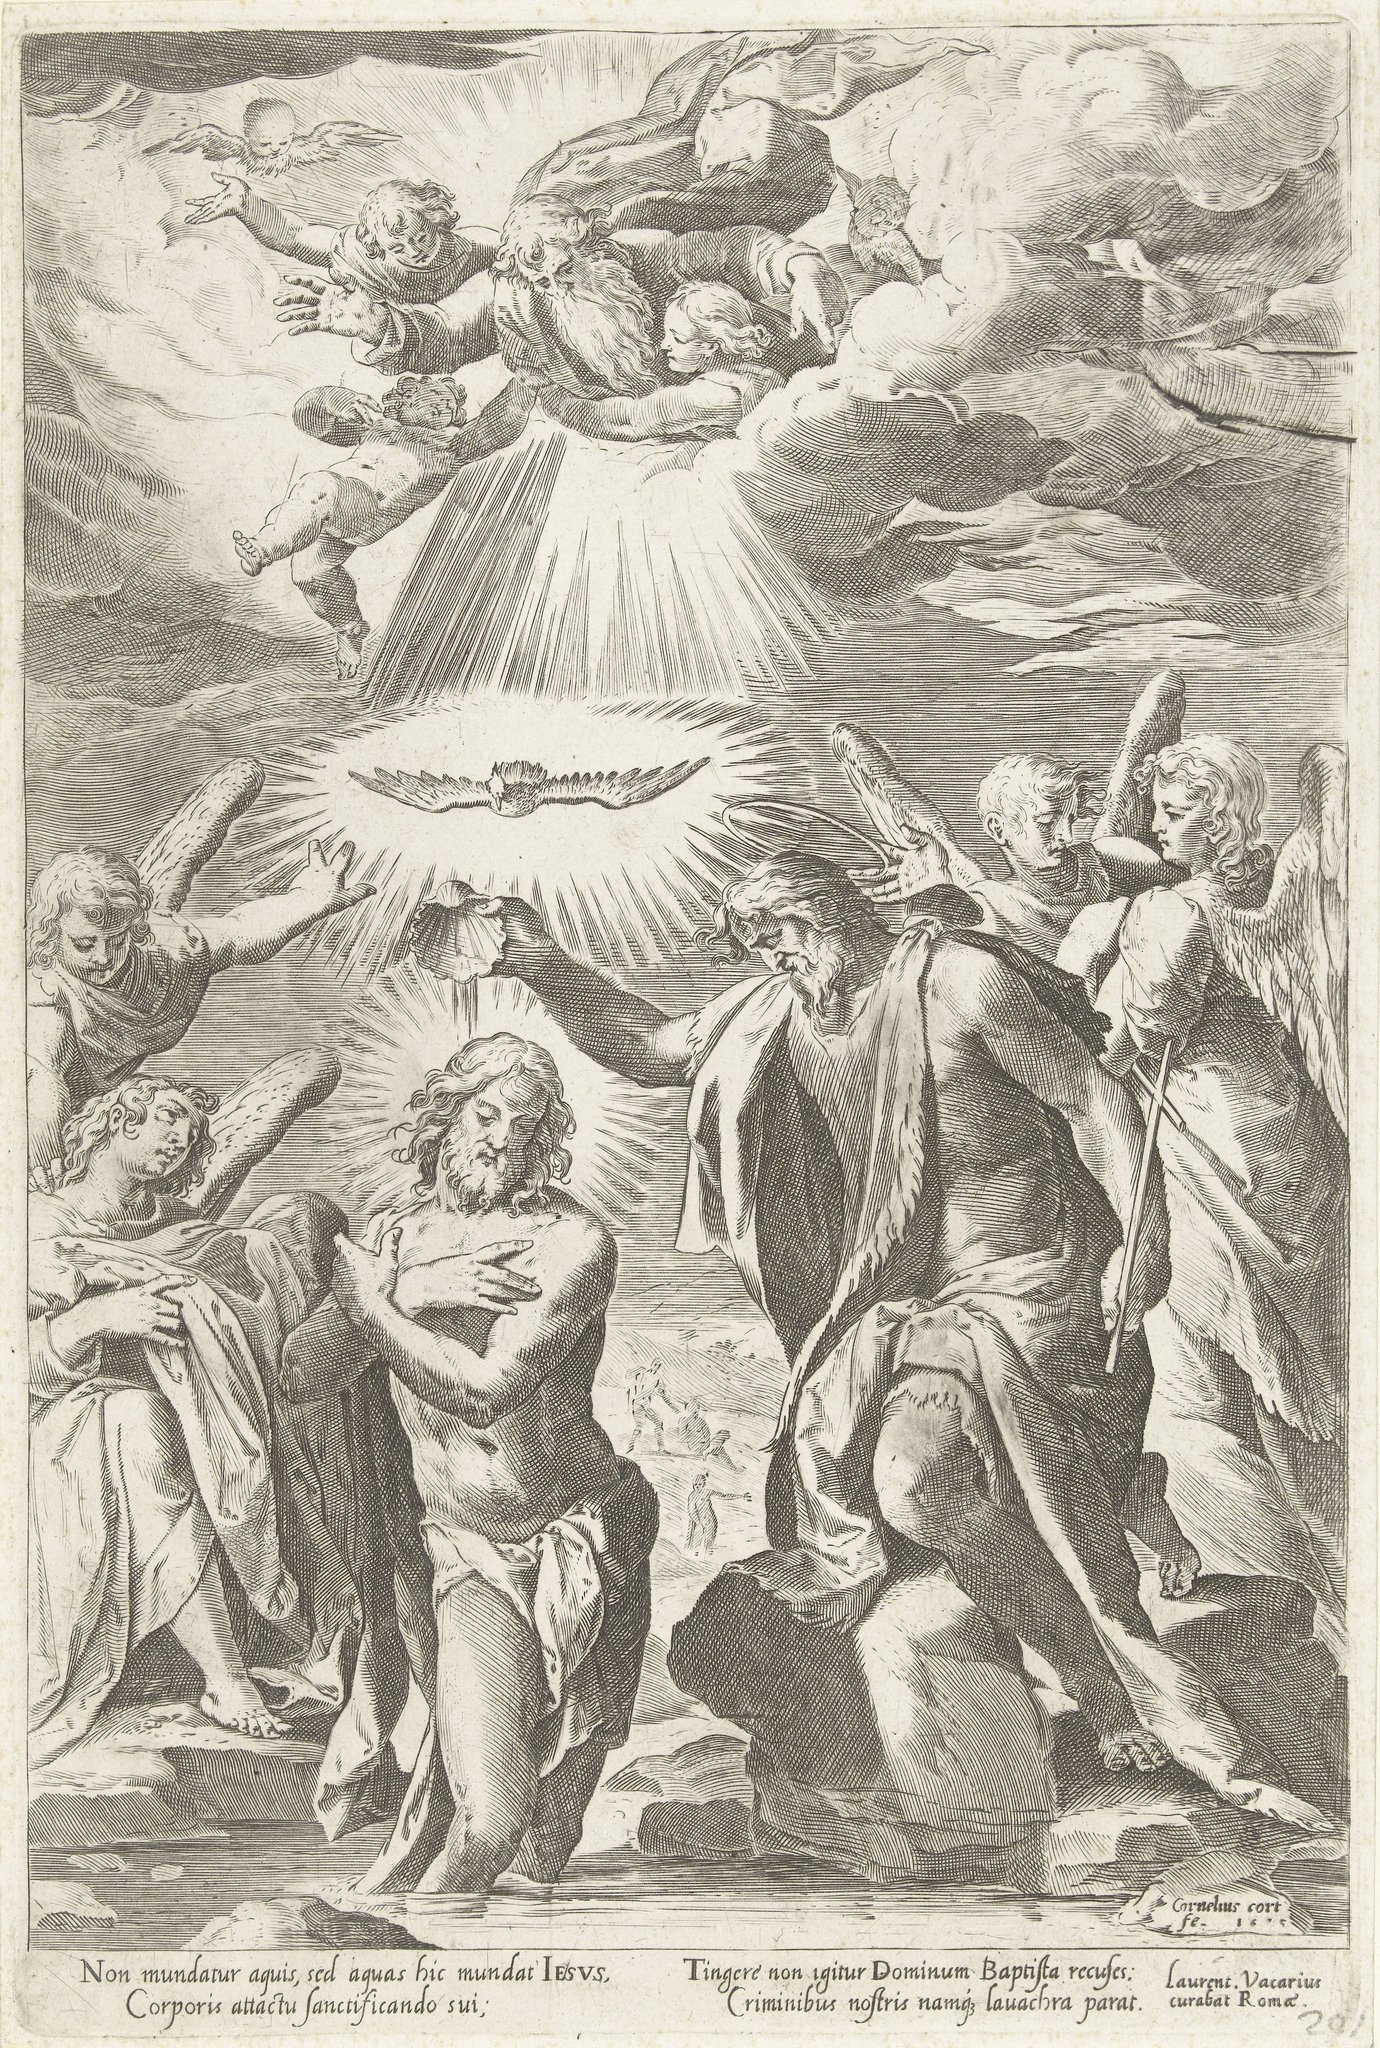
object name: print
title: Doop van Christus in de Jordaan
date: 1575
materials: paper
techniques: engraving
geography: rome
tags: baptism of christ in the river jordan: john the baptist pouring out water on christ's head: the holy ghost descends, angels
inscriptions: collector's mark: Lugt 2228, signature: ‘Cornelius cort fe.’, address: ‘Laurent. Vacarius / curabat Romae’, caption: ‘Non mundatur aquis, sed aquas hic mundat Iesus, / Corporis attactu sanctificando sui; / Tingere non igitur Dominum Baptista recuses; / Criminibus nostris namq[ue] lavachra parat.’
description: Christus staat met zijn voeten in het water van de rivier, de handen gevouwen voor de borst. Johannes de Doper giet water over zijn hoofd. Boven hem de H. Geest in de gedaante van een duif en God als oude man, met engeltjes in een lichtgevende wolk. Vier engelen kijken toe.